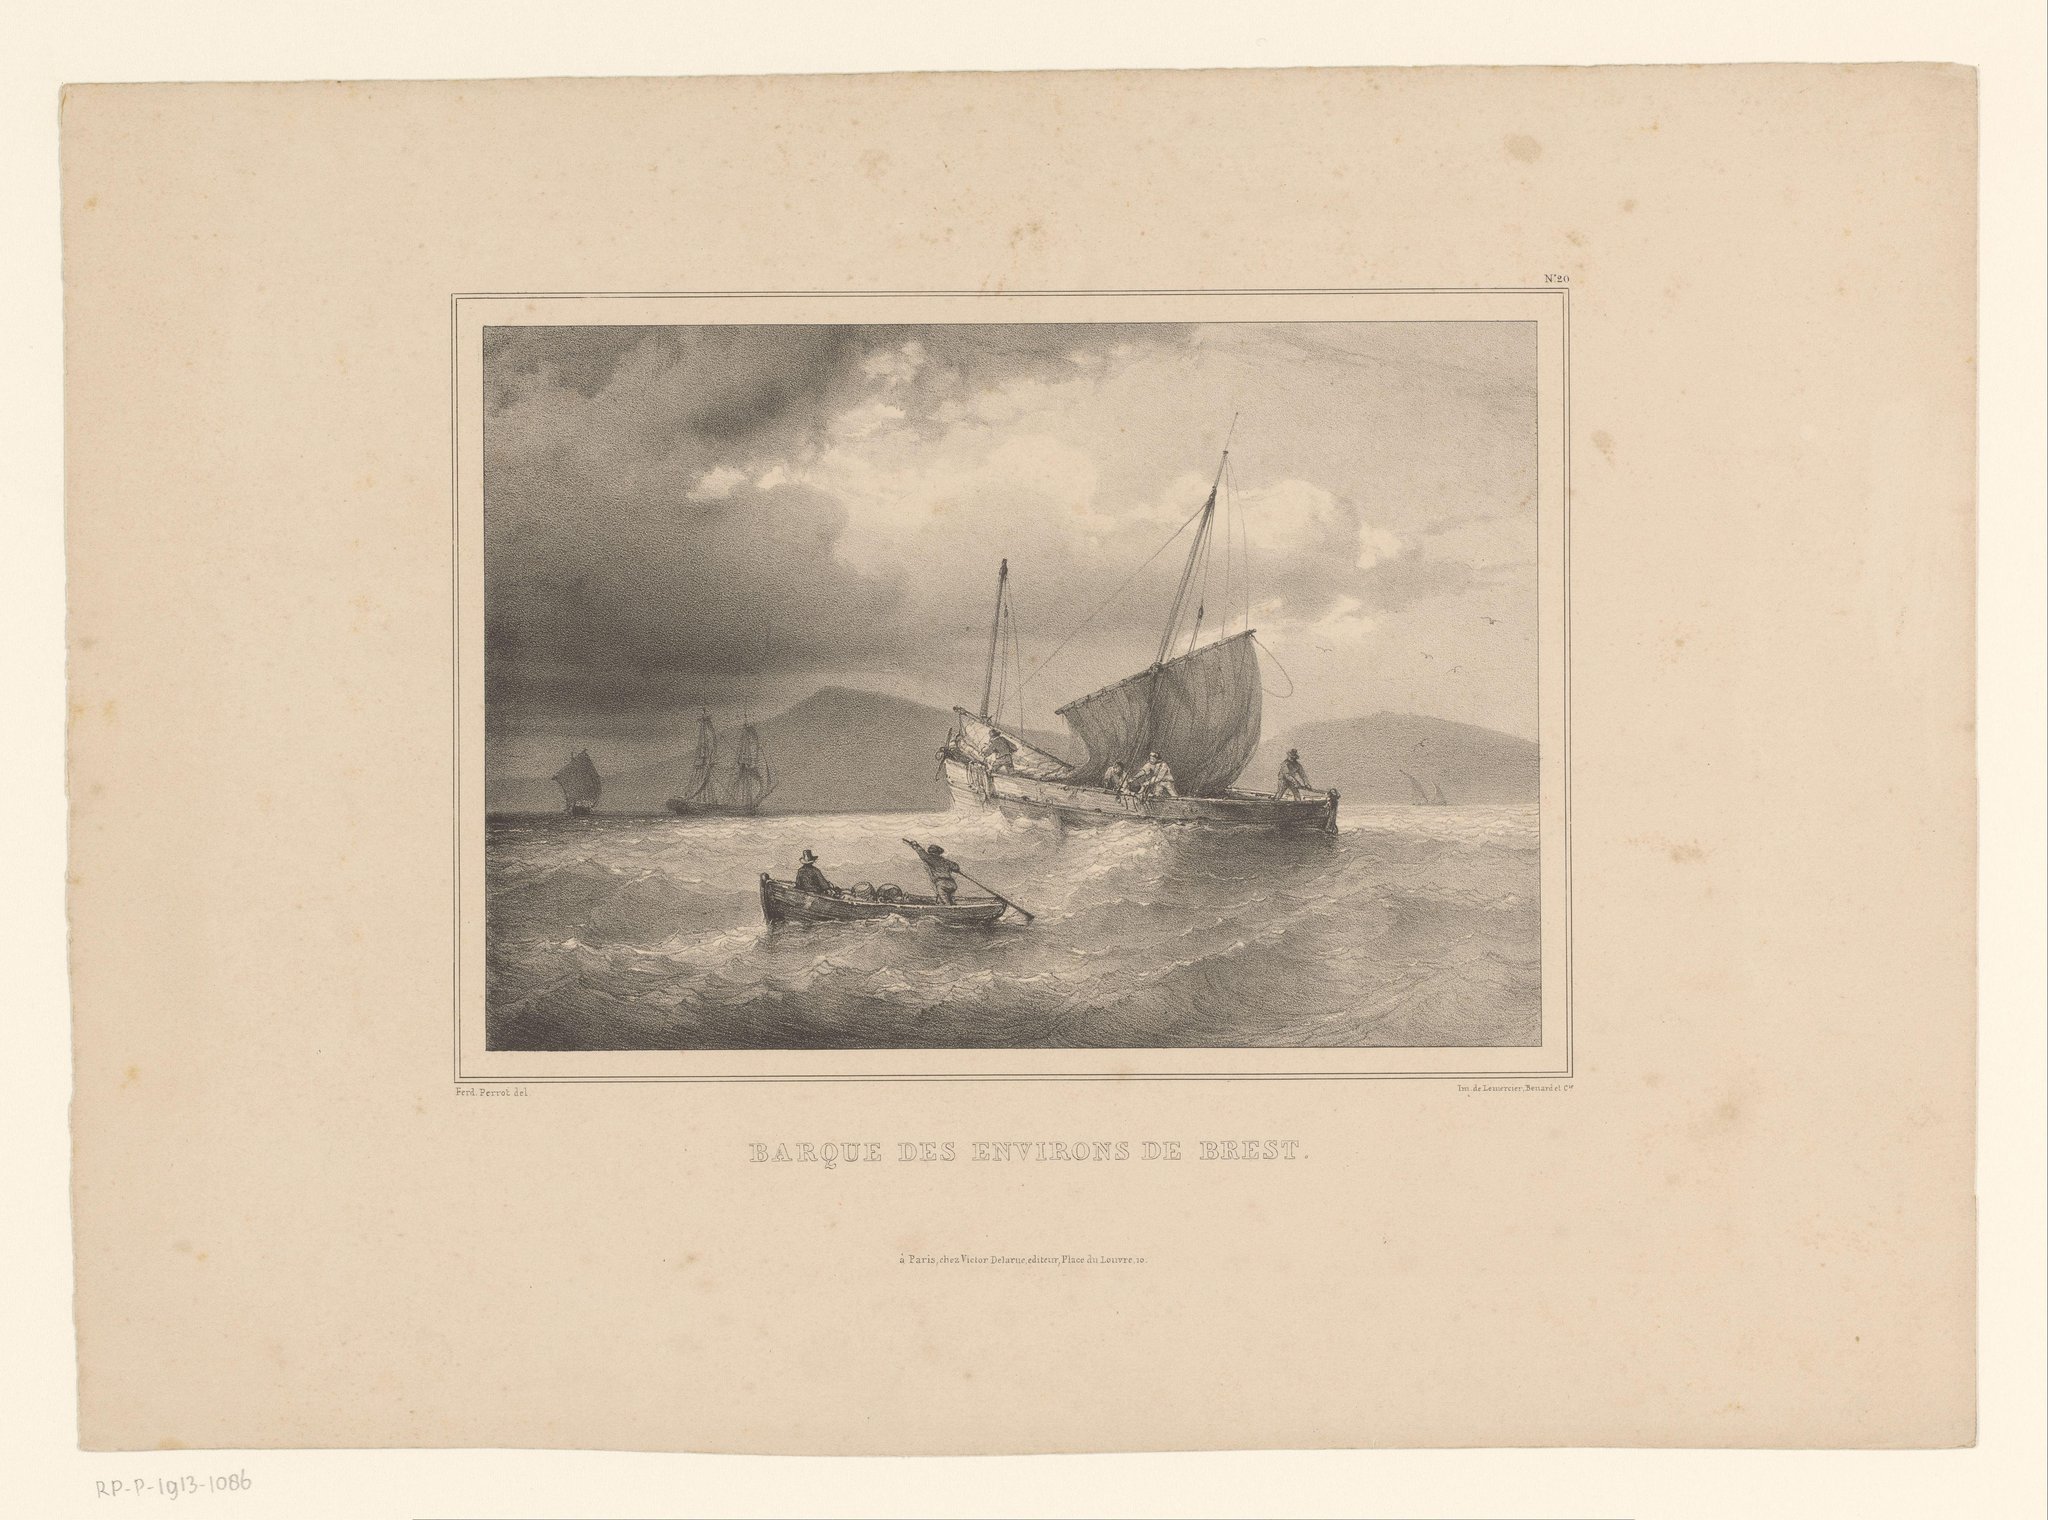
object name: print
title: Marinestudies door Ferdinand Victor Perrot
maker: ferdinand victor perrot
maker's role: print maker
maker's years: 1808-1841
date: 1837-1843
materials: paper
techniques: lithograph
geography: paris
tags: sailing-ship, sailing-boat, rowing-boat, canoe, etc., ships (in general) - cc - more than one ship, sea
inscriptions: collector's mark: Lugt 2228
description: Er zijn meerdere prentseries met marinestudies door Ferdinand Victor Perrot verschenen, het is onduidelijk om hoeveel series het gaat en tot welke serie deze prent precies behoort.